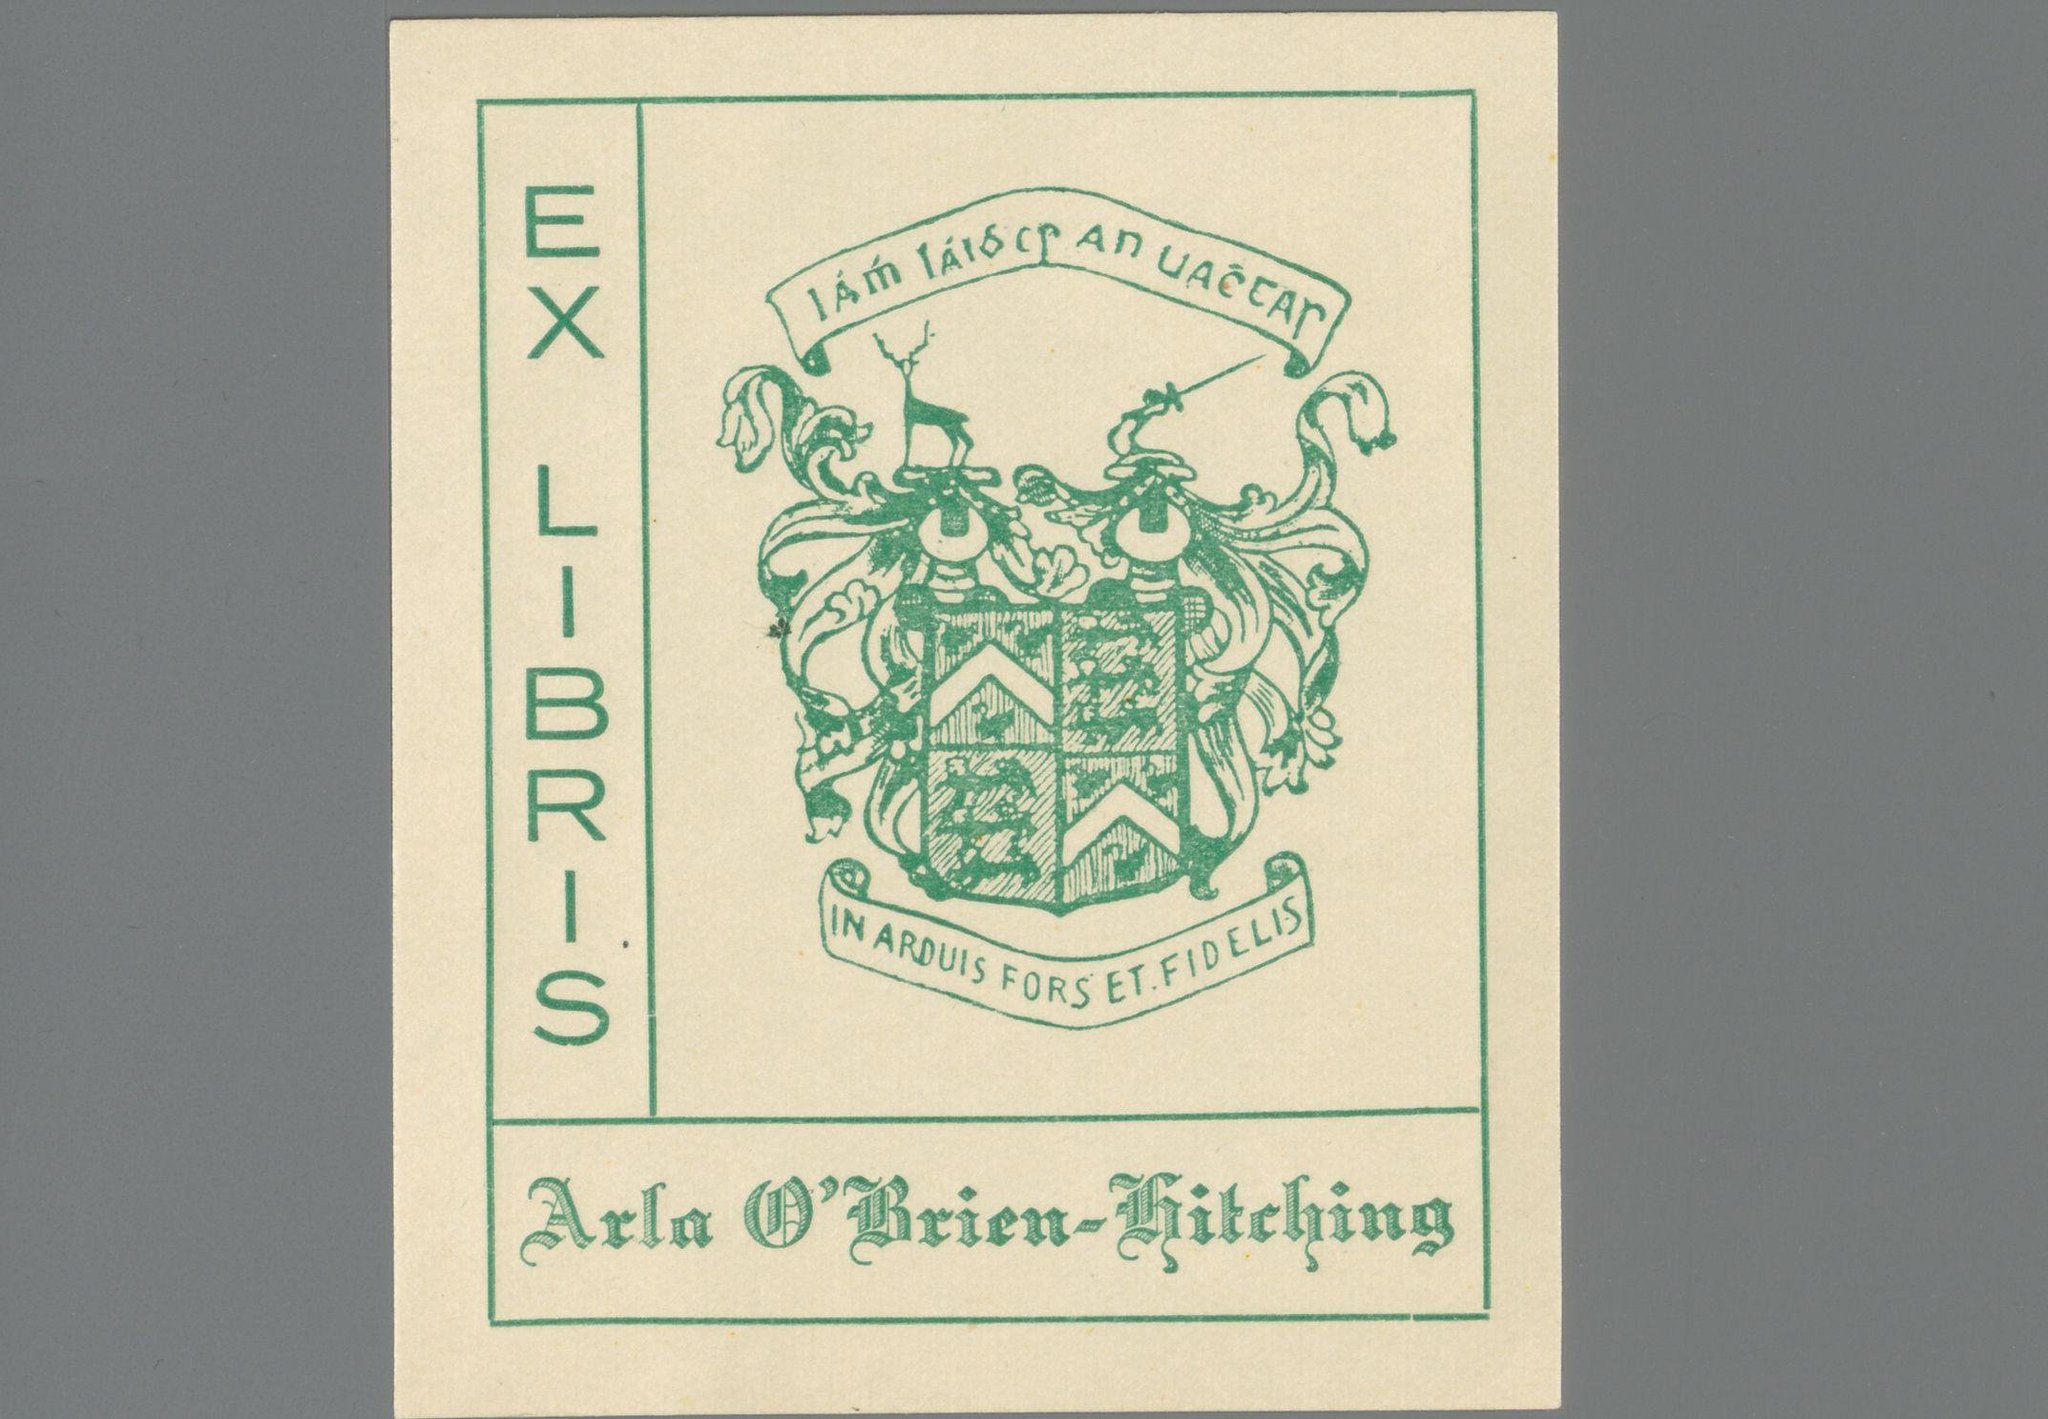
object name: bookplate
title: In arduis fors et fidelis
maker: Anonymous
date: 1900-1959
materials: paper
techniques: autotype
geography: england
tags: hoofed animals: stag, hacking and thrusting weapons: sword, armorial bearing, heraldry